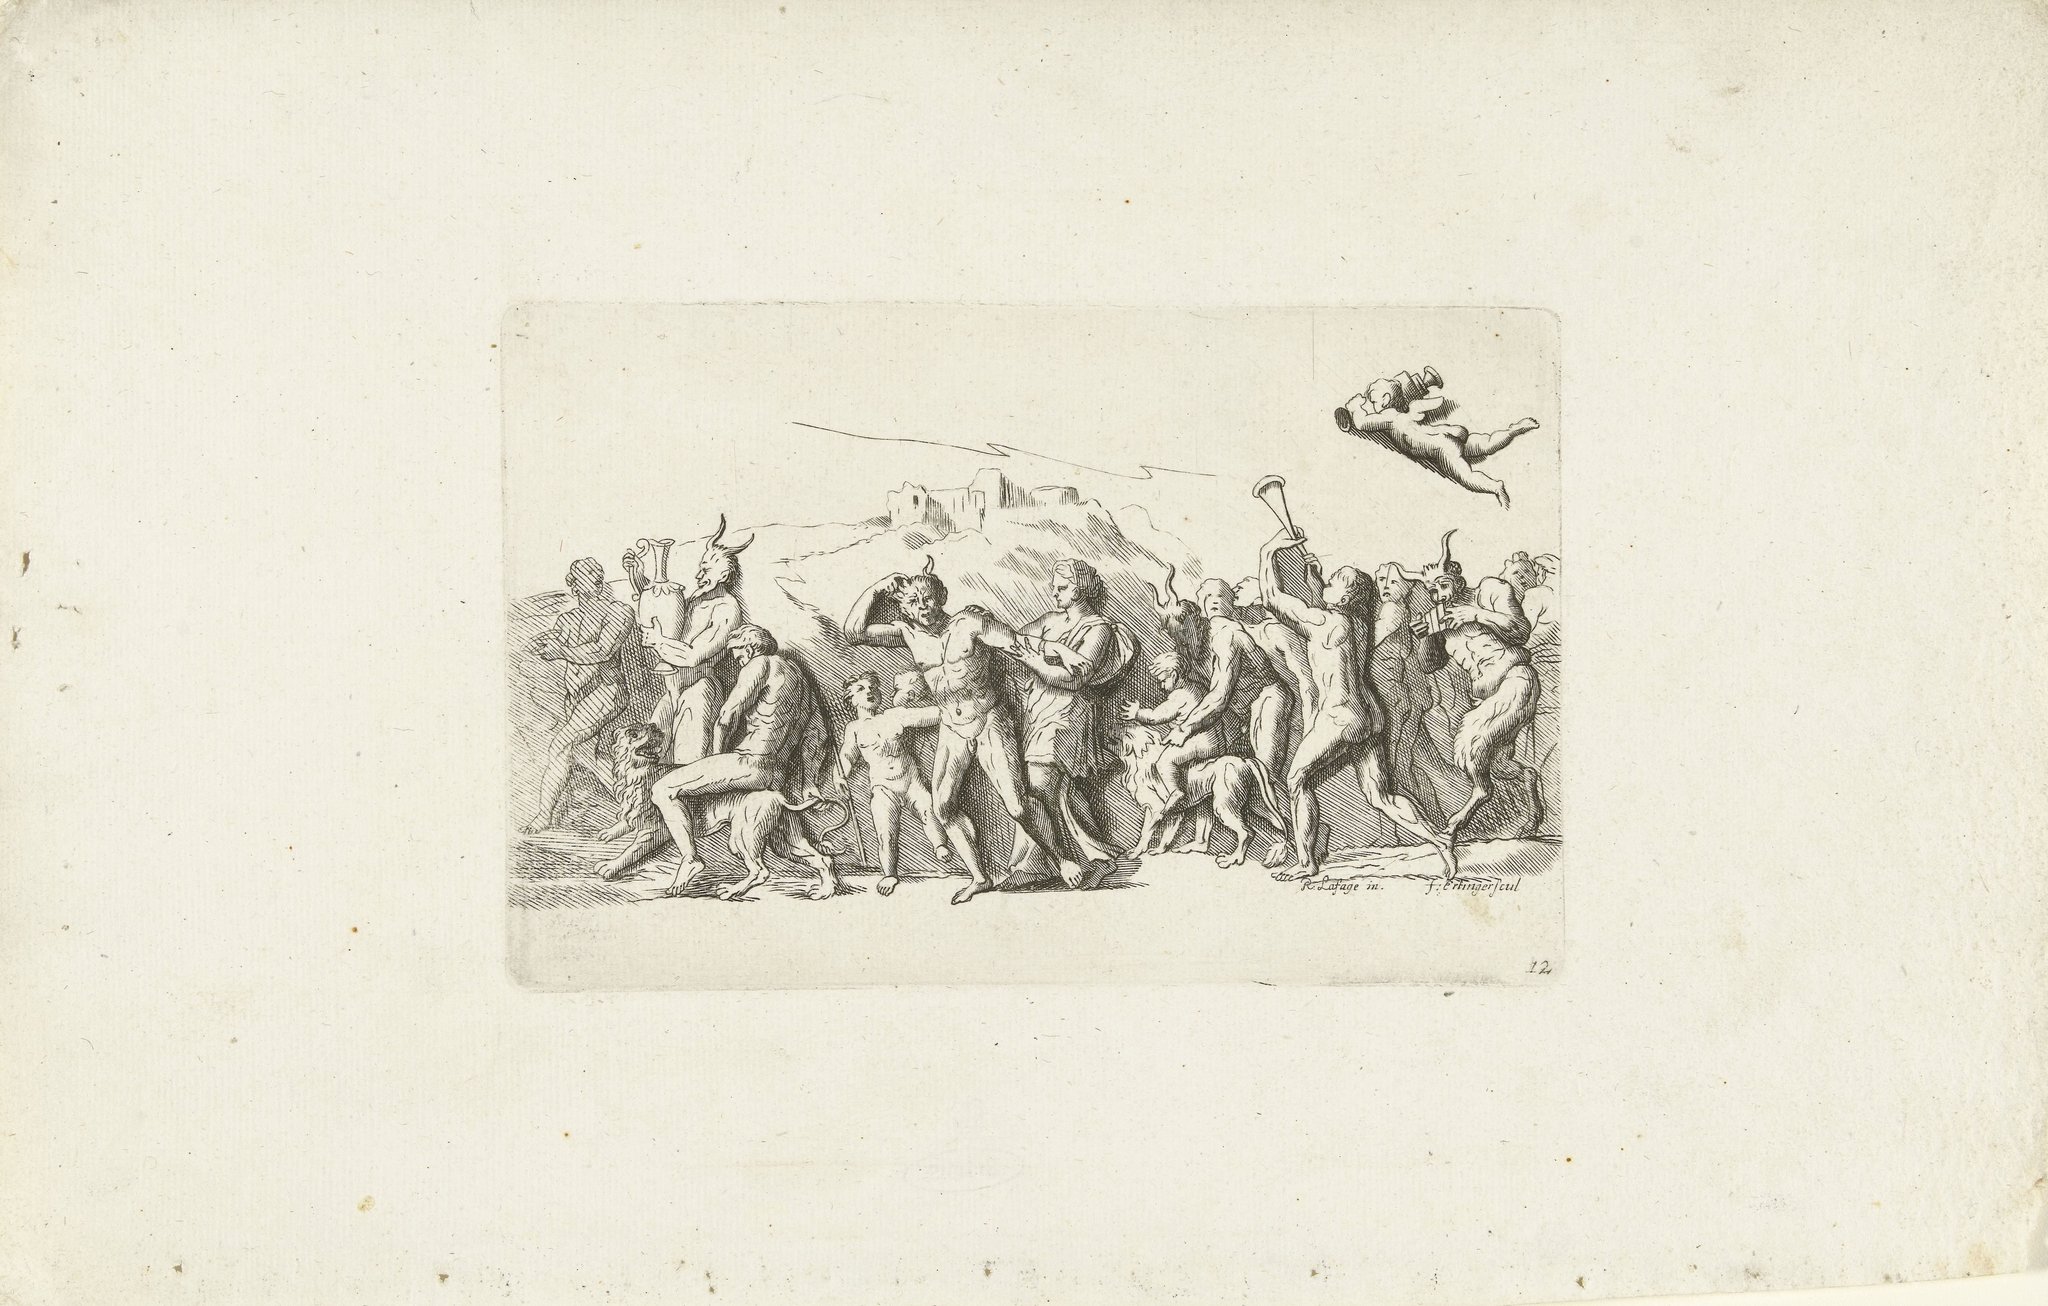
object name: print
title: Bacchanten stoet met leeuwen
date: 1652-1707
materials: paper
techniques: engraving, etching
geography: france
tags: veneration of bacchus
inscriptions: collector's mark: Lugt 2760, collector's mark: Lugt 2228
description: Een optocht met mannen, vrouwen en satyrs. Een naakte man en een kind rijden op een leeuw, anderen musiceren. Boven de stoet vliegt een putto met een vaas.